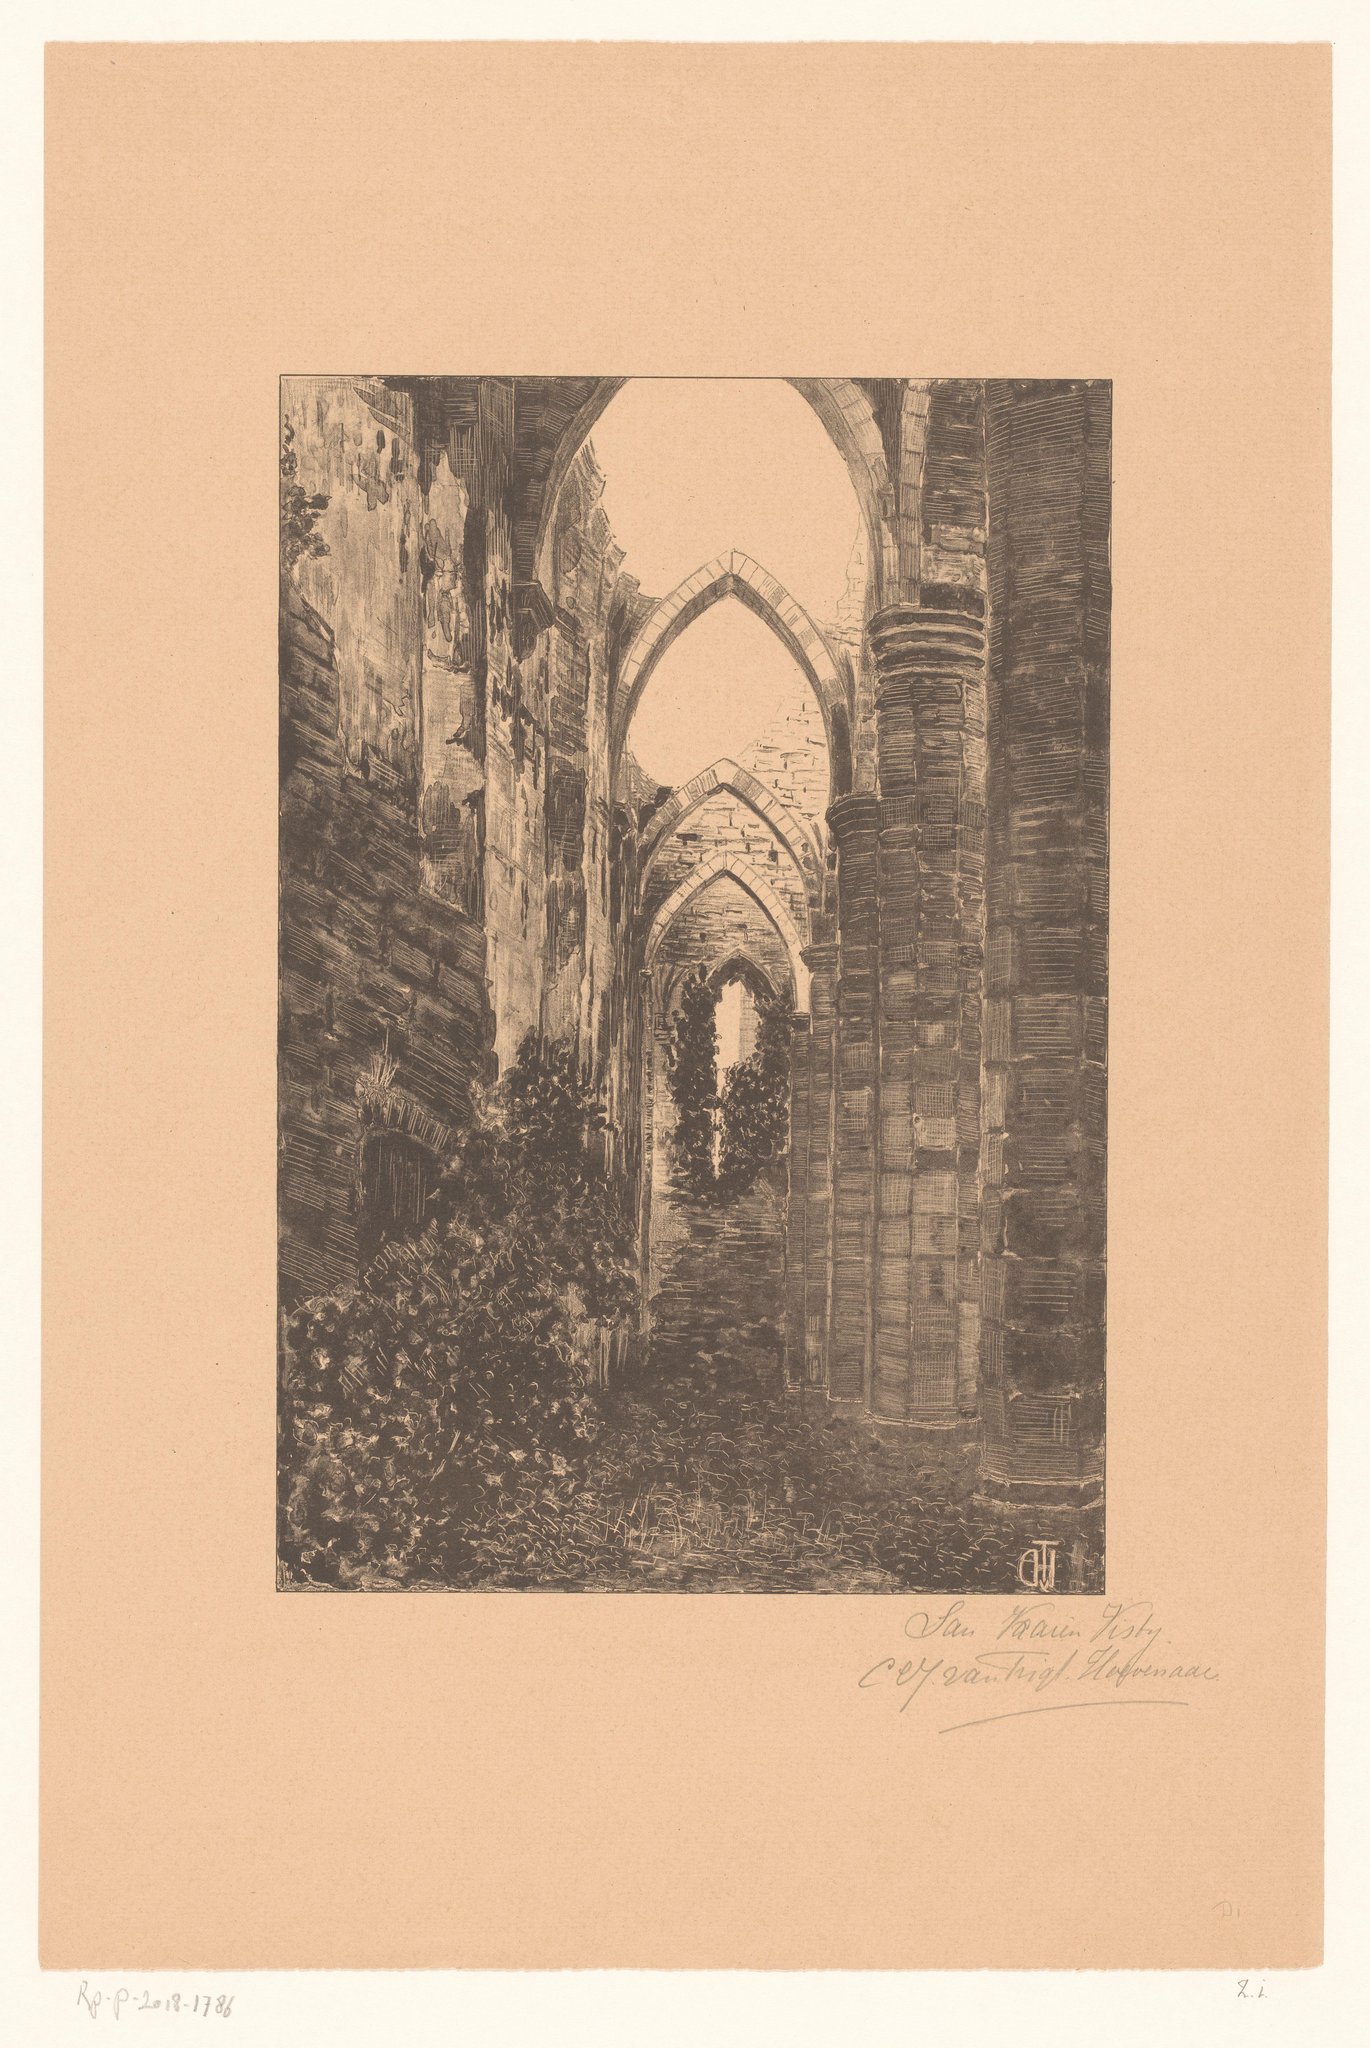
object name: print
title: Ruïne van San Karin op Visby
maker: cornelia christina johanna van trigt-hoevenaar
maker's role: print maker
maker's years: 1854-1924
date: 1864-1909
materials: paper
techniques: lithograph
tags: ruin of church, monastery, etc.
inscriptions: collector's mark: Lugt 2228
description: Zicht vanuit overwoekerde zijbeuk waarvan het dak ontbreekt.